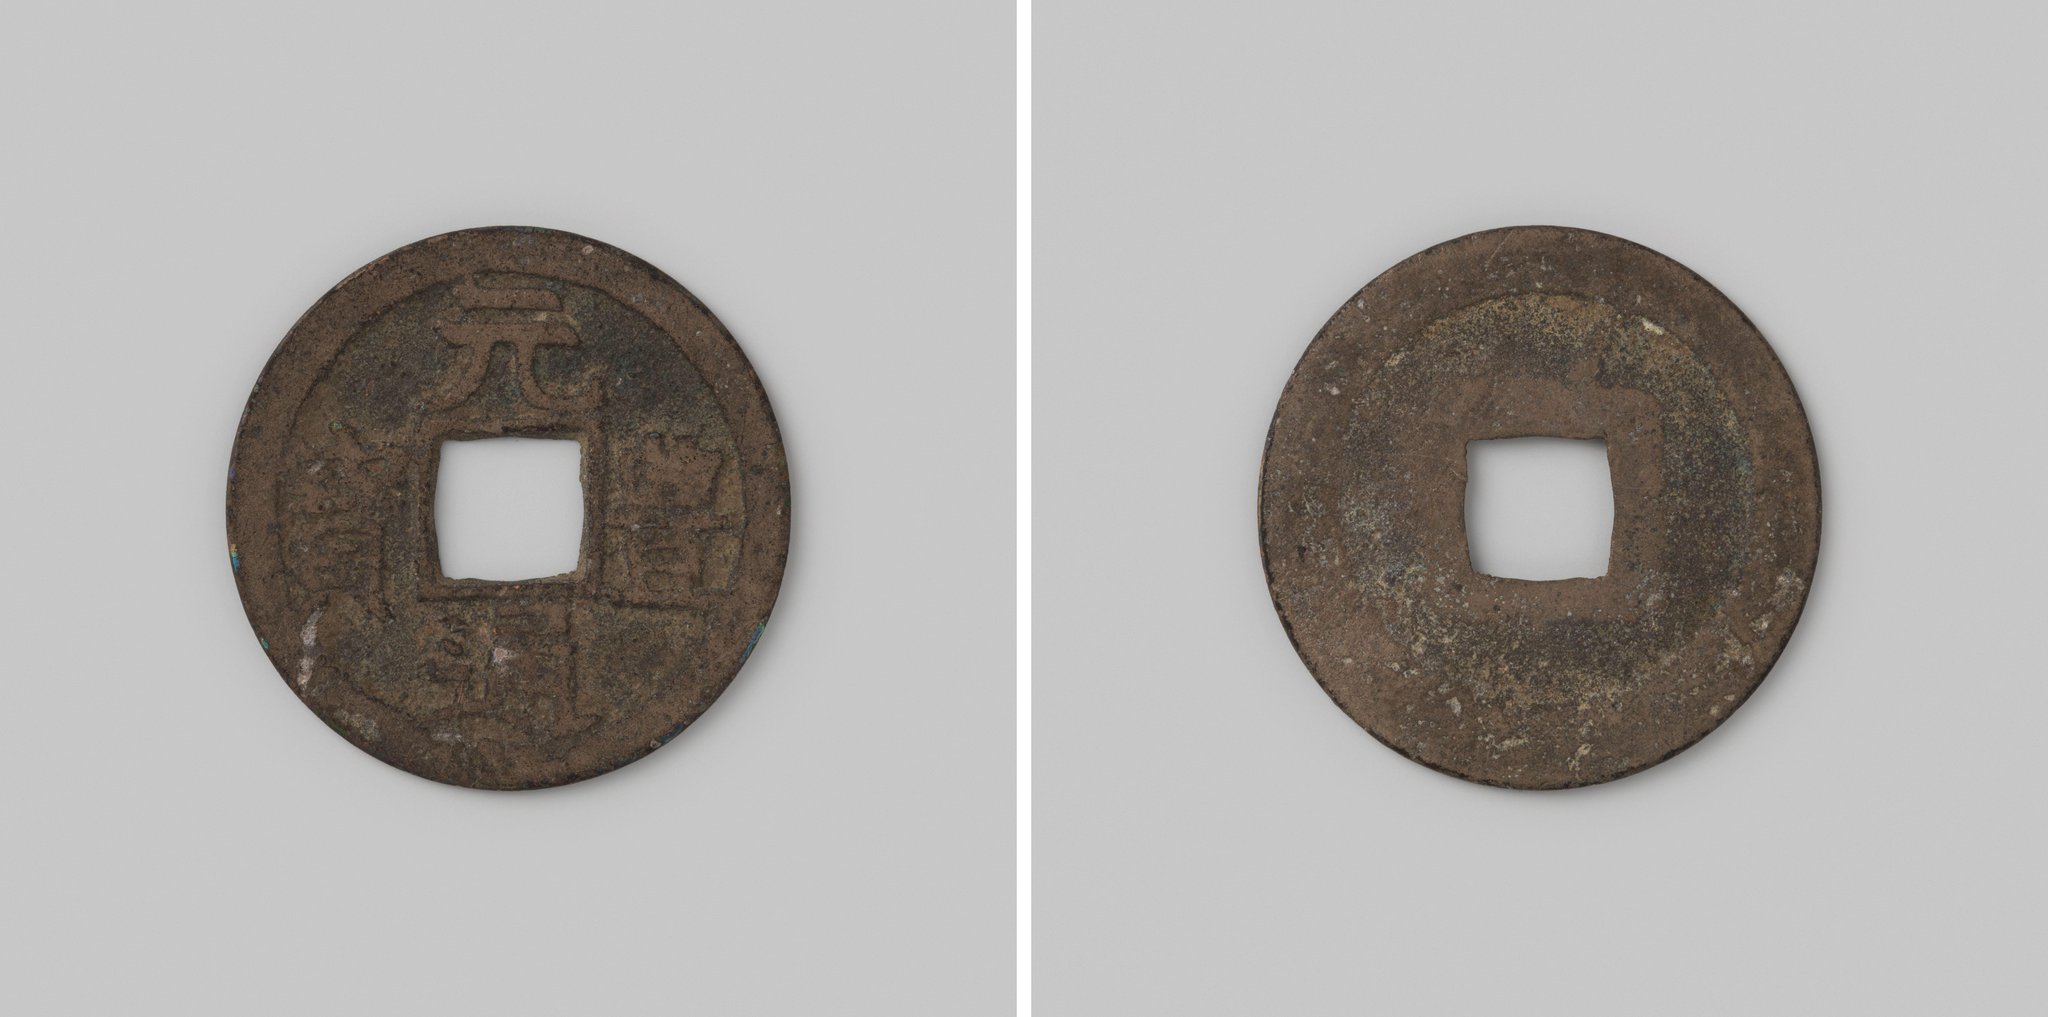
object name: coin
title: Cash van het keizerrijk China van keizer Shen Tsung onder de regeringsnaam Yuan-Feng,1078 -1085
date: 1078-1085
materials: copper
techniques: casting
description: Koperen munt. Voorzijde: binnen brede opstaande rand rondom vierkante uitsparing in het midden vier kruisgewijze geplaatste Chinese tekens, waarvan twee met de betekenis: Yuan feng. Keerzijde: glad binnen brede opstaande rand.